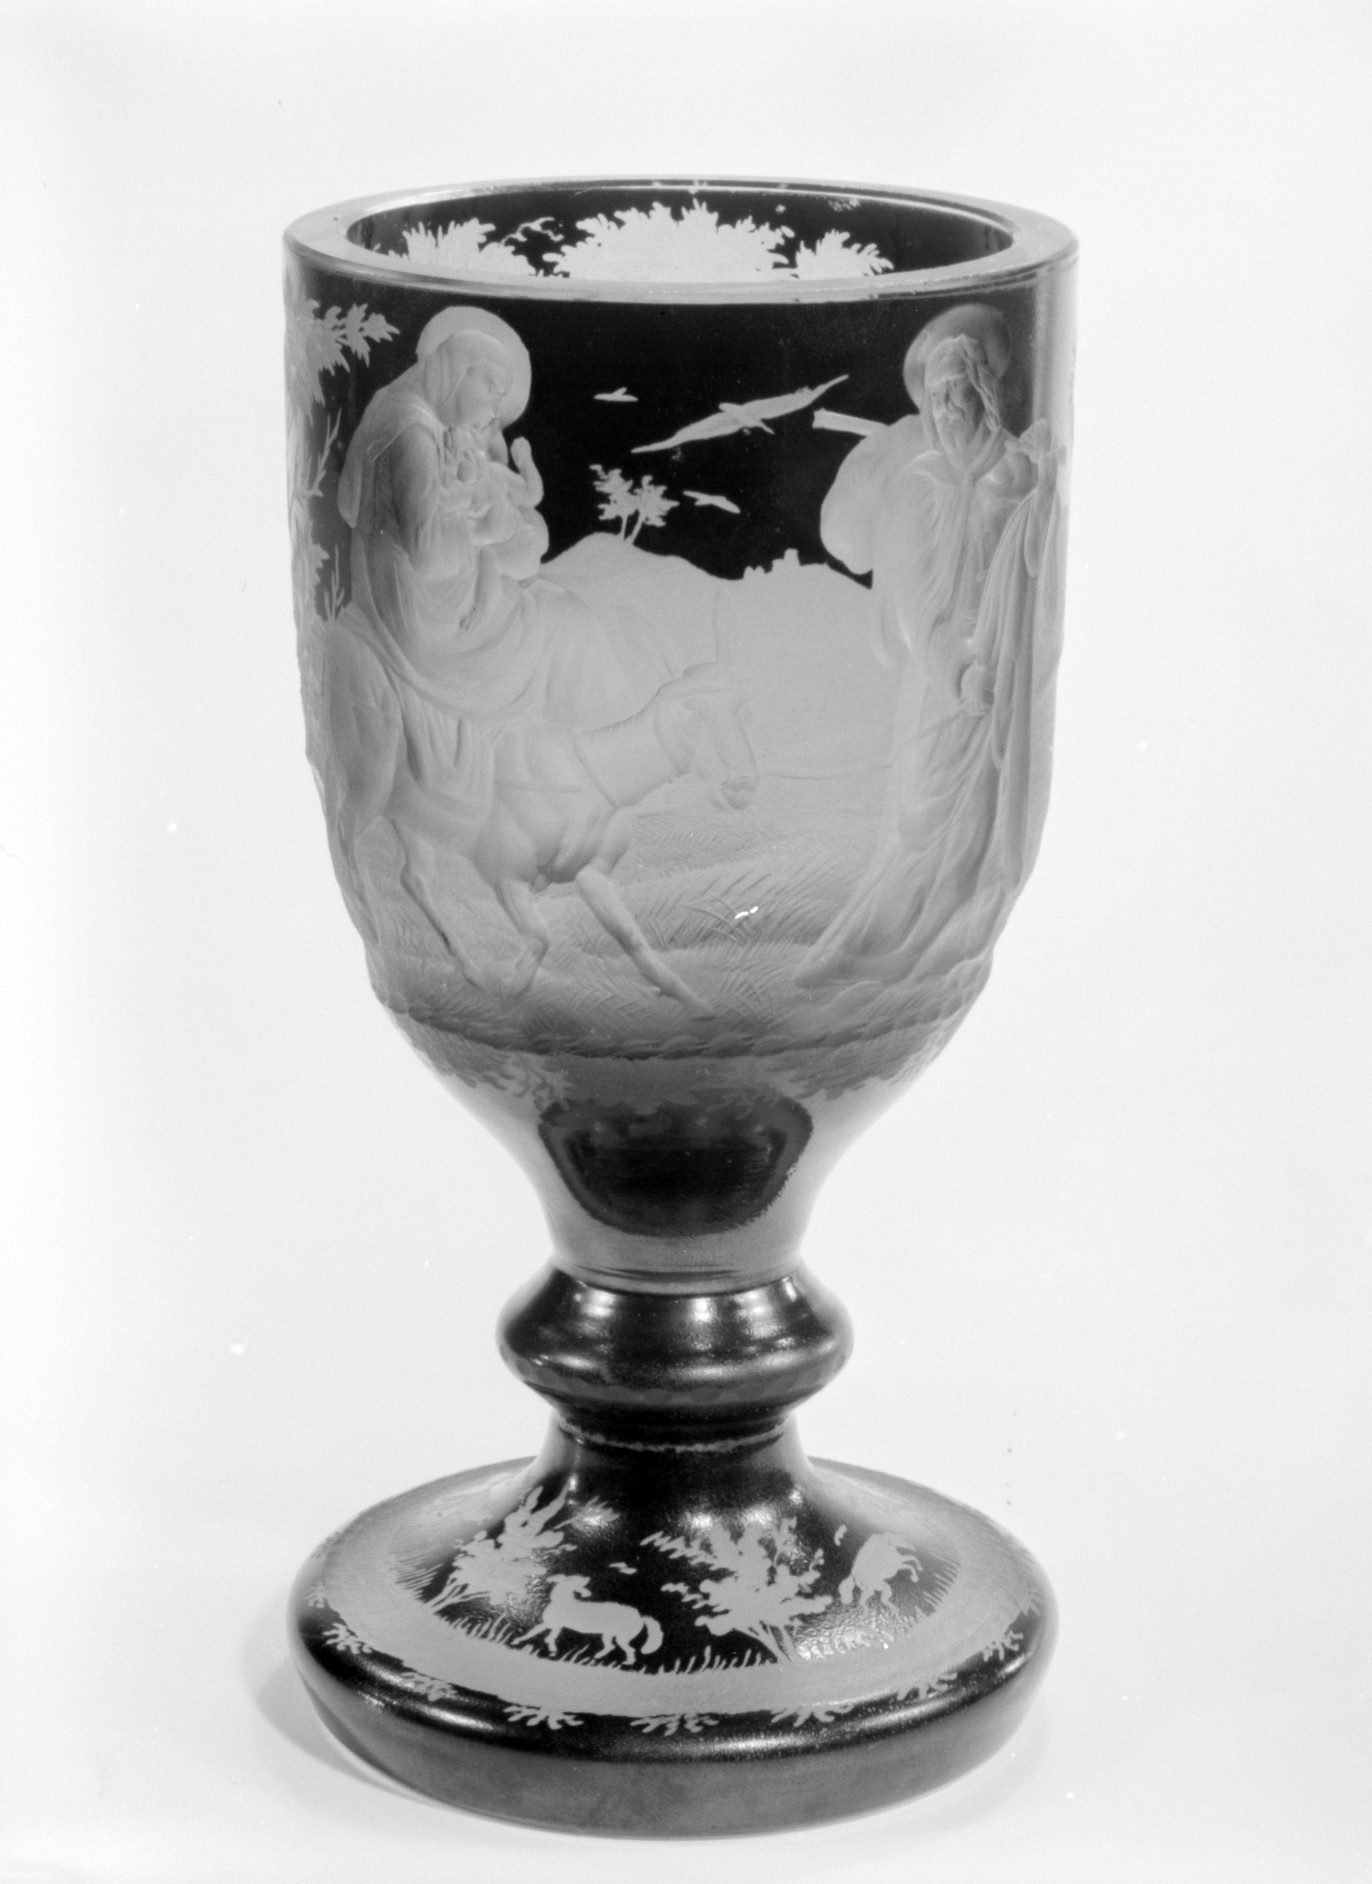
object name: goblet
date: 1826-1850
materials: glass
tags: virgin mary,jesus